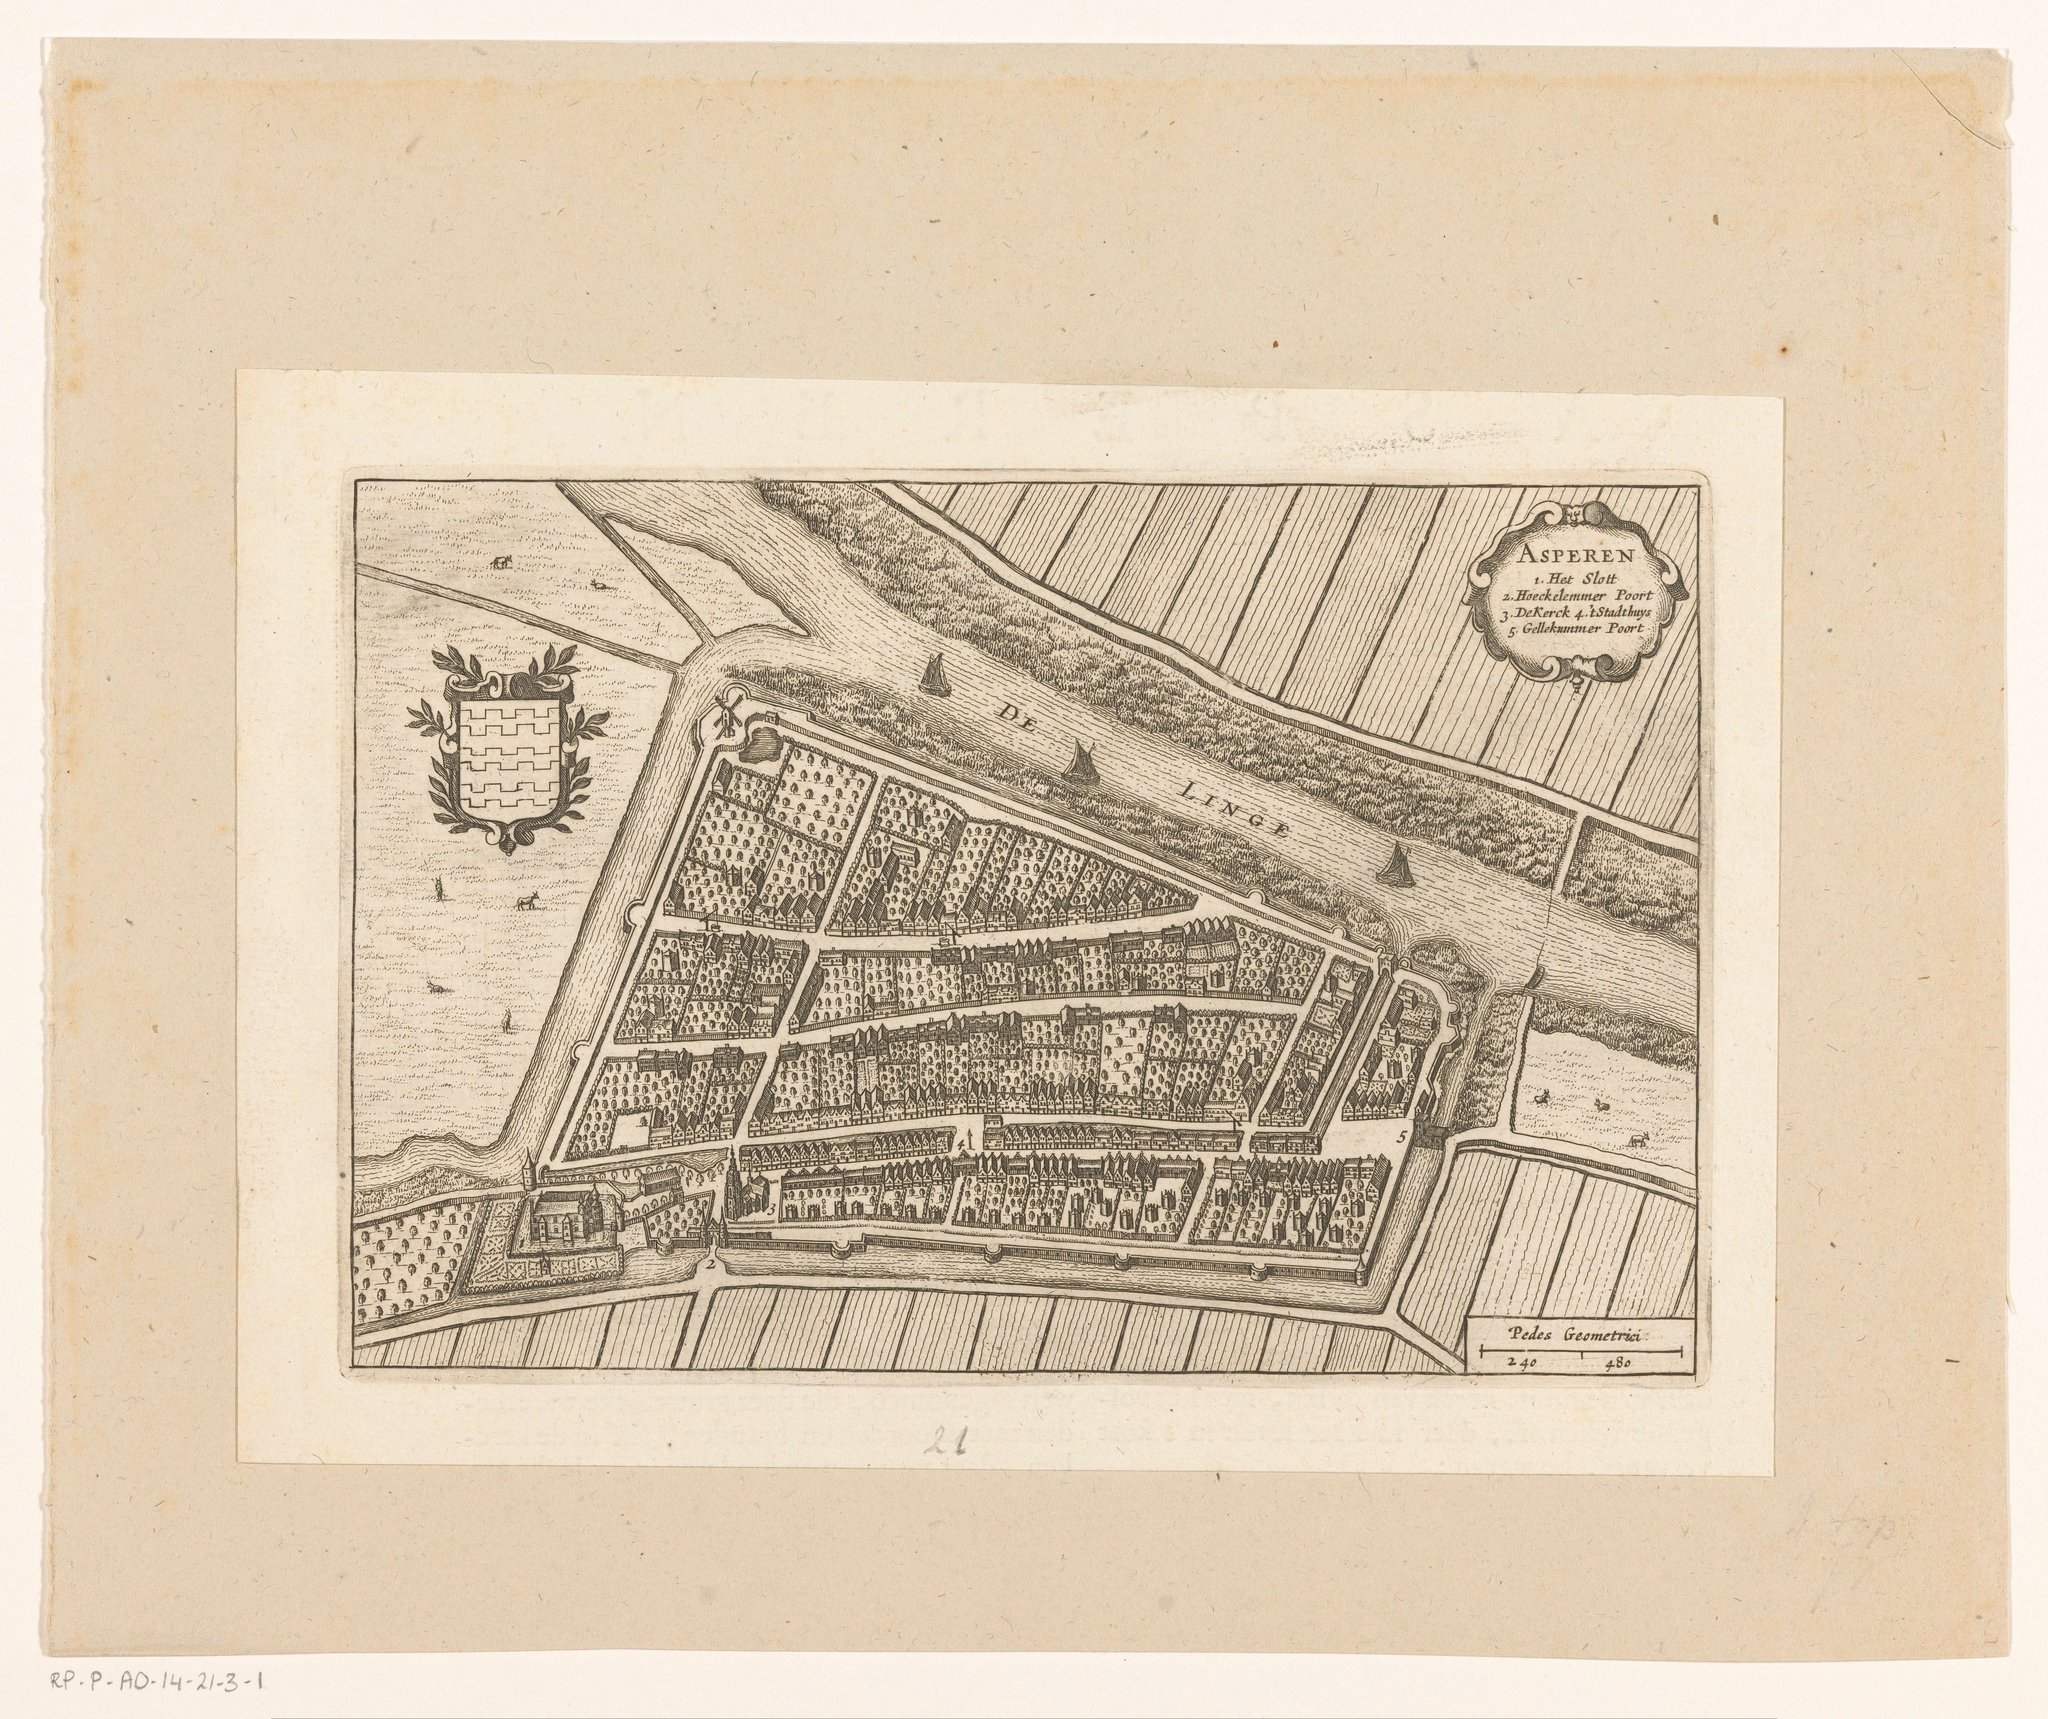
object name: print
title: Plattegrond van Asperen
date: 1632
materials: paper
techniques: engraving, etching, letterpress printing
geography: amsterdam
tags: coat of arms (as symbol of the state, etc.) (+ city; municipal), maps of cities, asperen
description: Prent gebruikt in: Blaeu, Johannes Willemszoon. Toonneel der steden van de Vereenighde Nederlanden. 2 delen. Amsterdam: Johannes Willemszoon Blaeu, 1652, dl. 1. Prent voor het eerst ook gebruikt in: Boxhorn, Marcus Zuerius van. Theatrum sive Hollandiae comitatus et urbium nova descriptio (…). Amsterdam: Henricus Hondius, 1632.